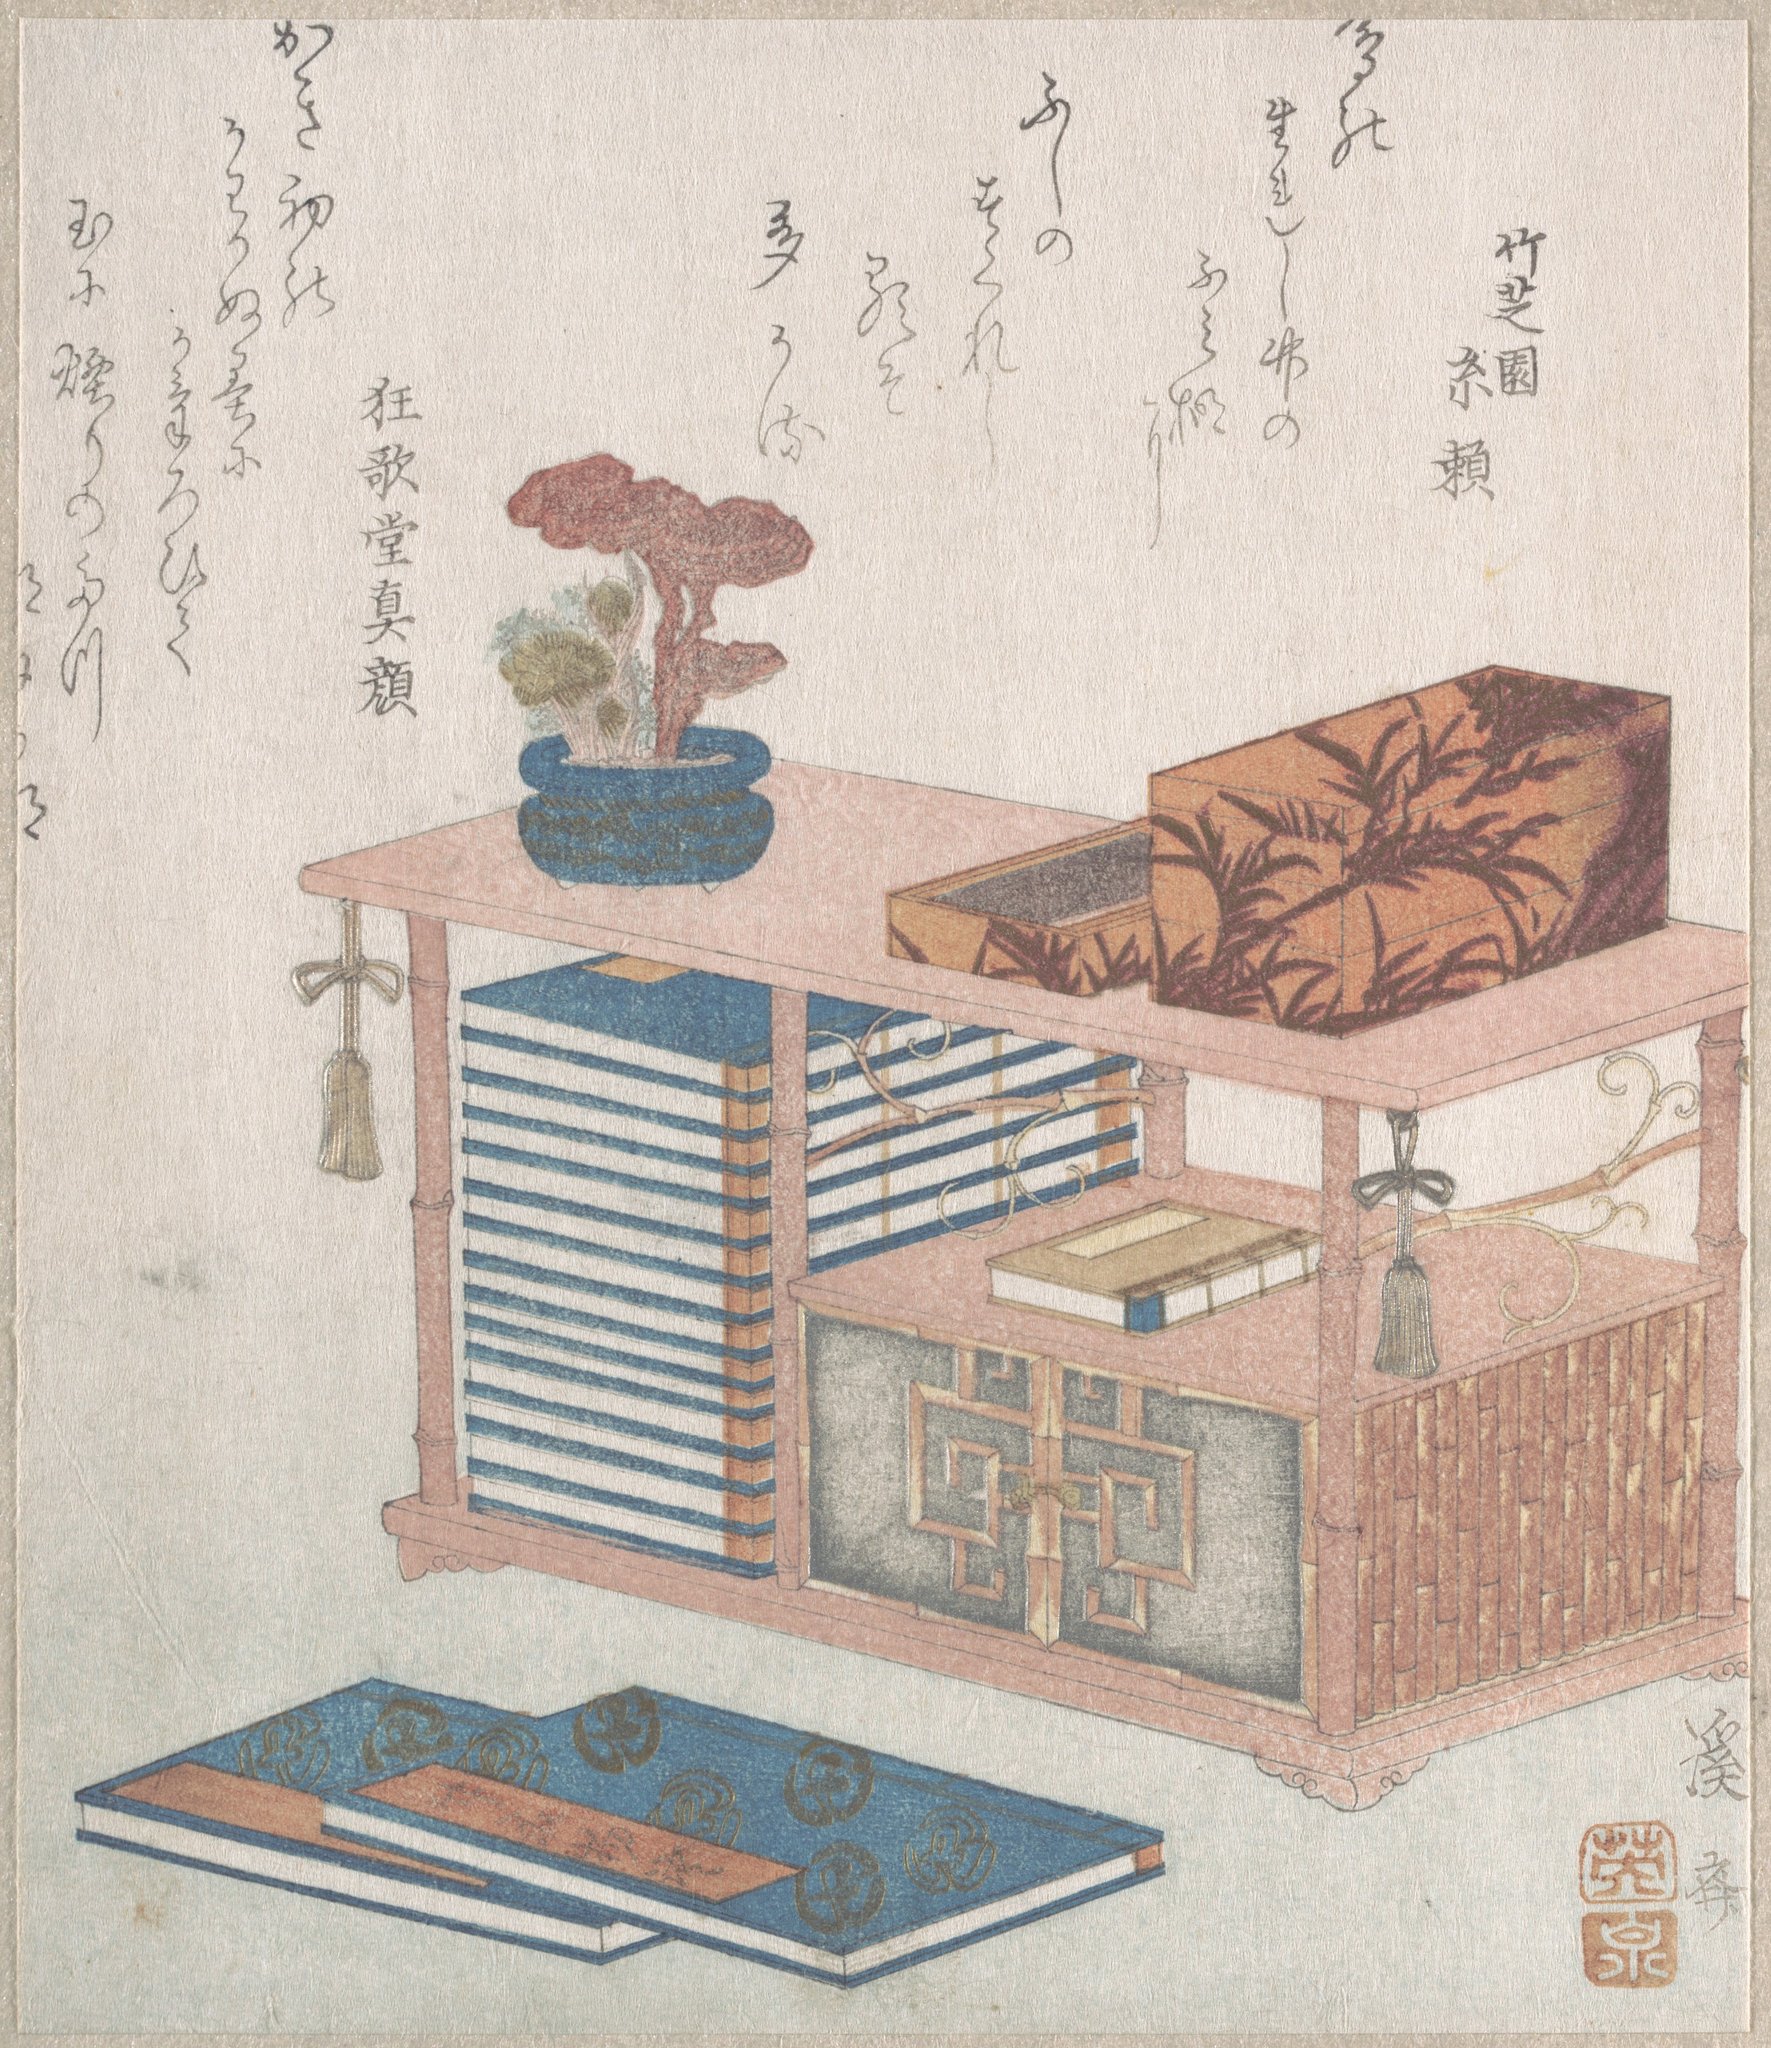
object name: woodblock print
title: Books and a Bookcase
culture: japanese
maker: keisai eisen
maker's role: artist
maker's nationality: japanese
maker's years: 1790-1848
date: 1801-1900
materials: ink, paper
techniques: surimono, woodblock print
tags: books,flowers,cabinets